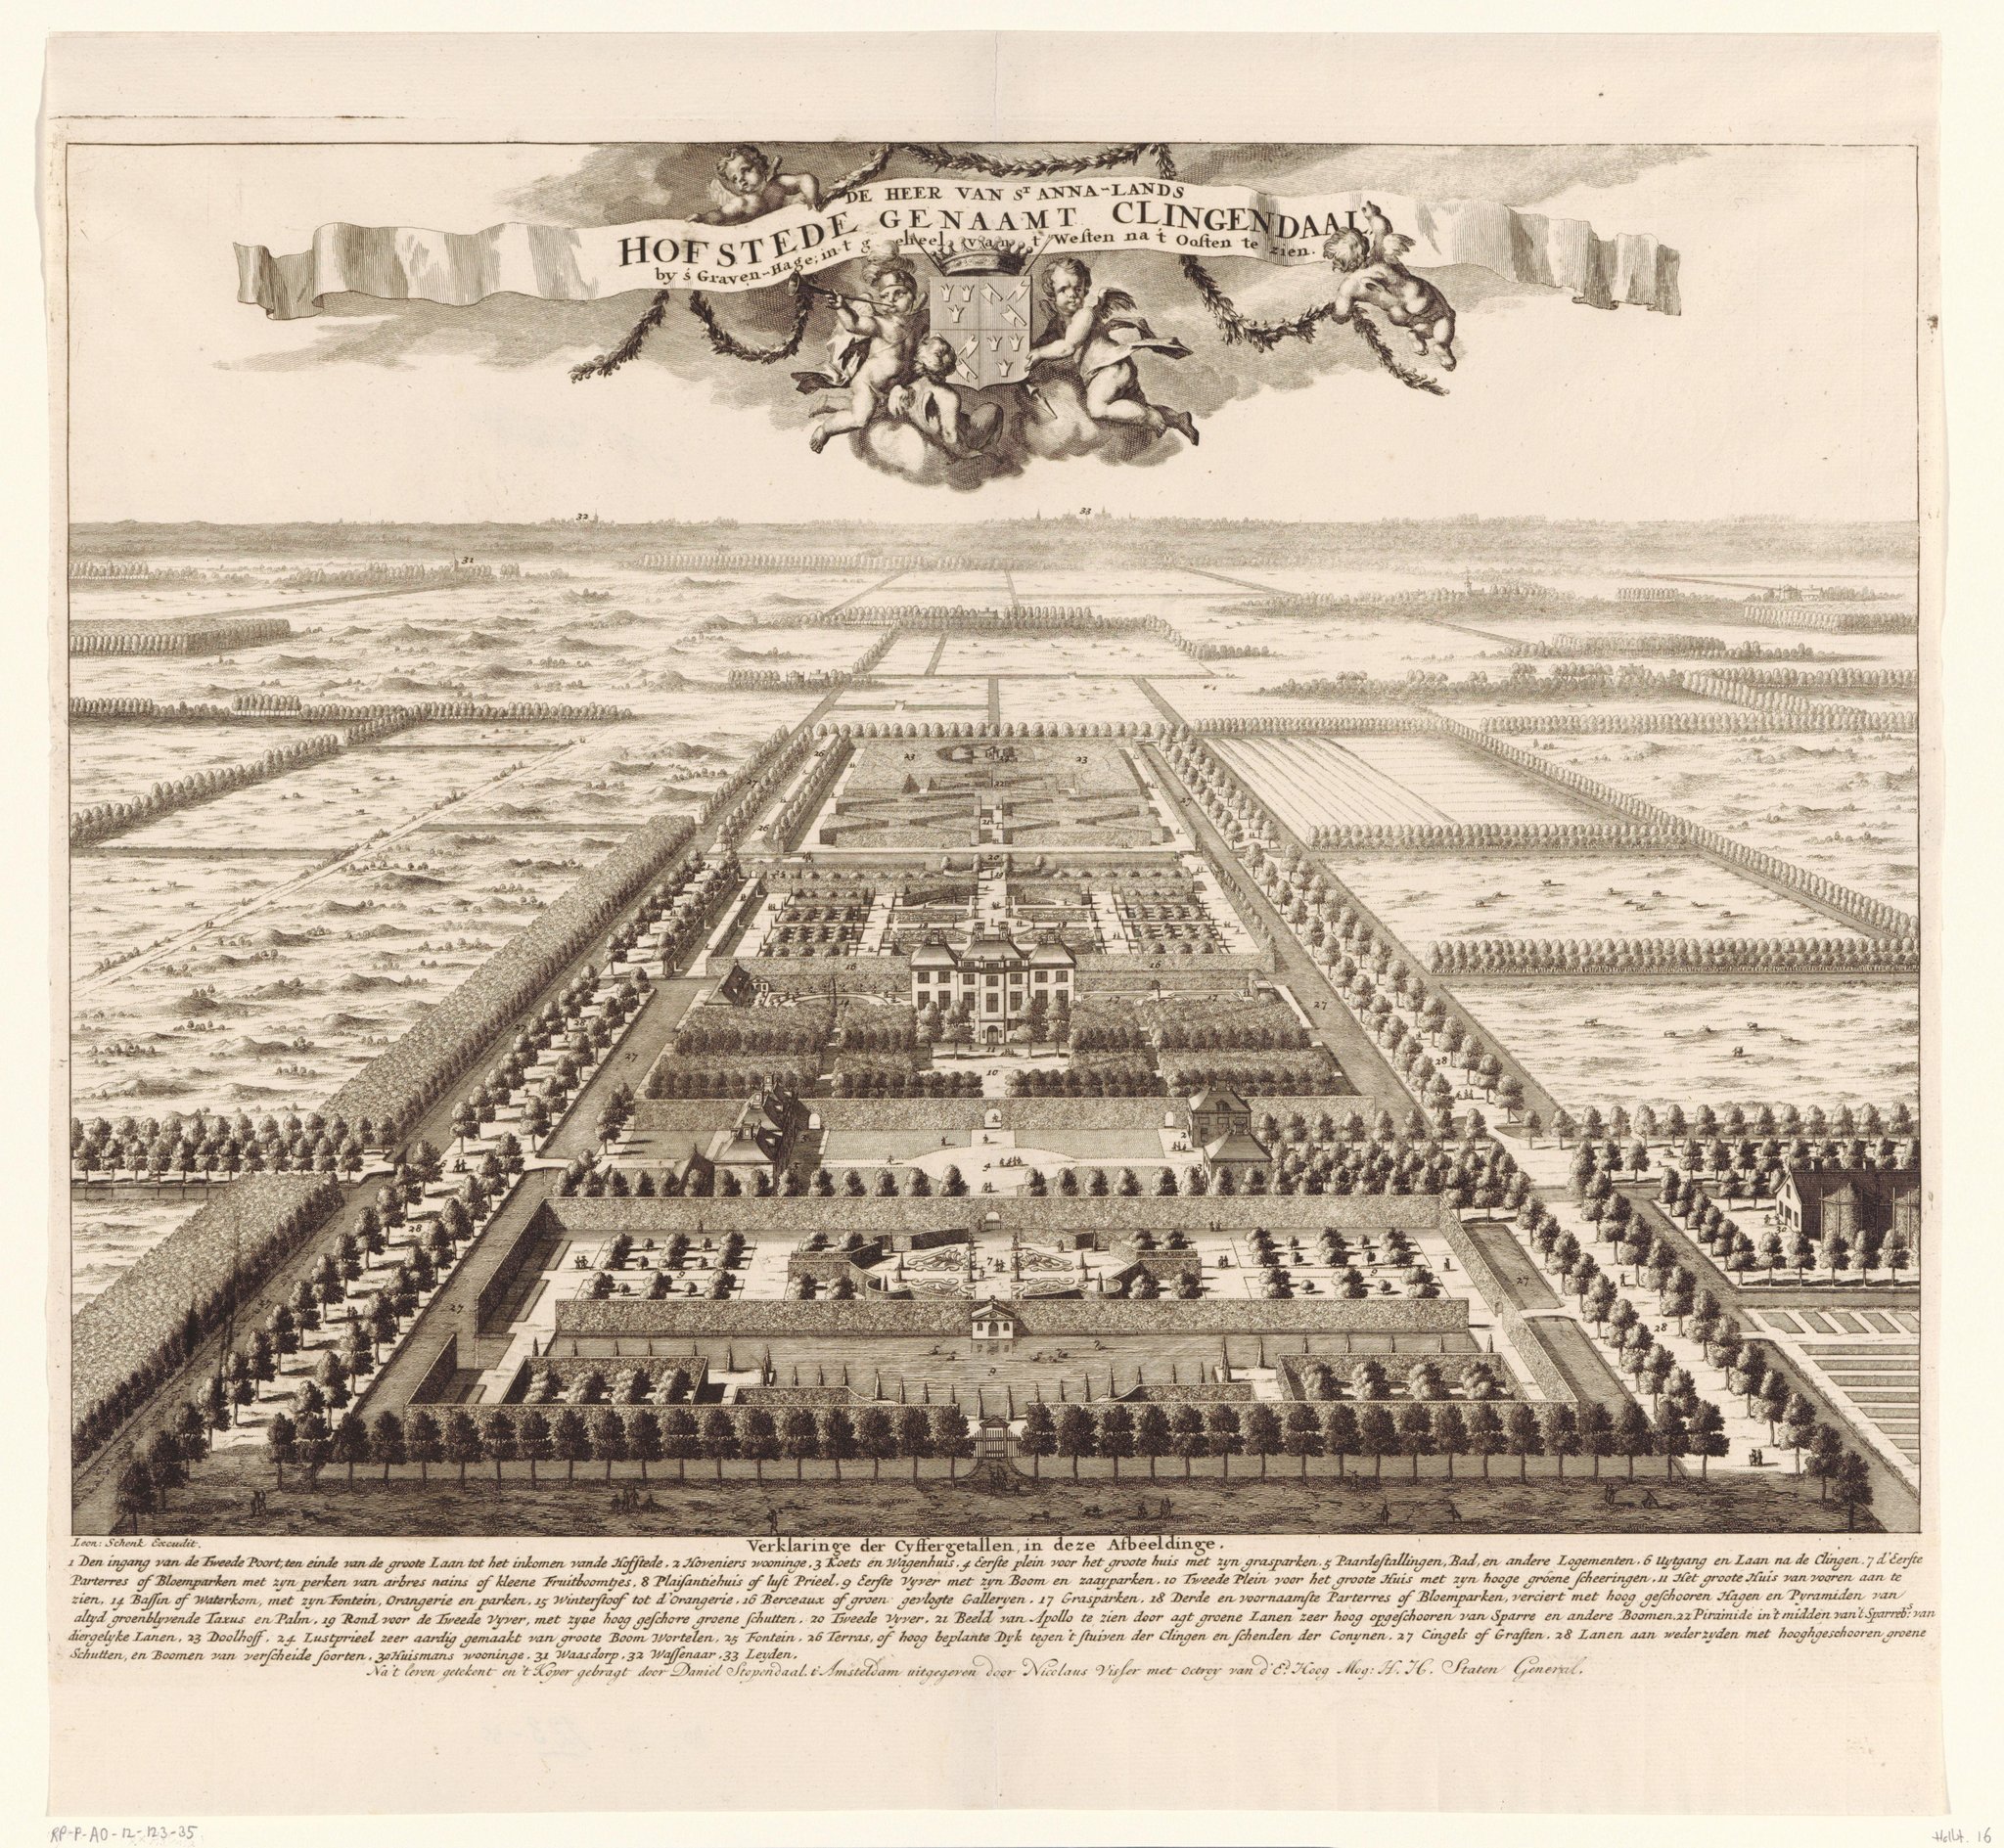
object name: print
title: De Heer van St. Anna-Lands Hofstede Genaamt Clingendaal bij 's Graven-hage; in 't geheel van t Westen na 't Oosten te zien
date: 1682-1726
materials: paper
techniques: etching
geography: amsterdam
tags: french or architectonic garden; formal garden, bird's eye view ~ representation of building, cupids: 'amores', 'amoretti', 'putti', armorial bearing, heraldry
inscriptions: collector's mark: Lugt 2228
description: Gezicht op landgoed Clingendael in vogelvlucht. Aan de horizon Wassenaar en Leiden. Midden boven een door putti geflankeerde wimpel en het wapenschild van de eigenaar Philips Doublet. Middenonder in de marge een legenda.